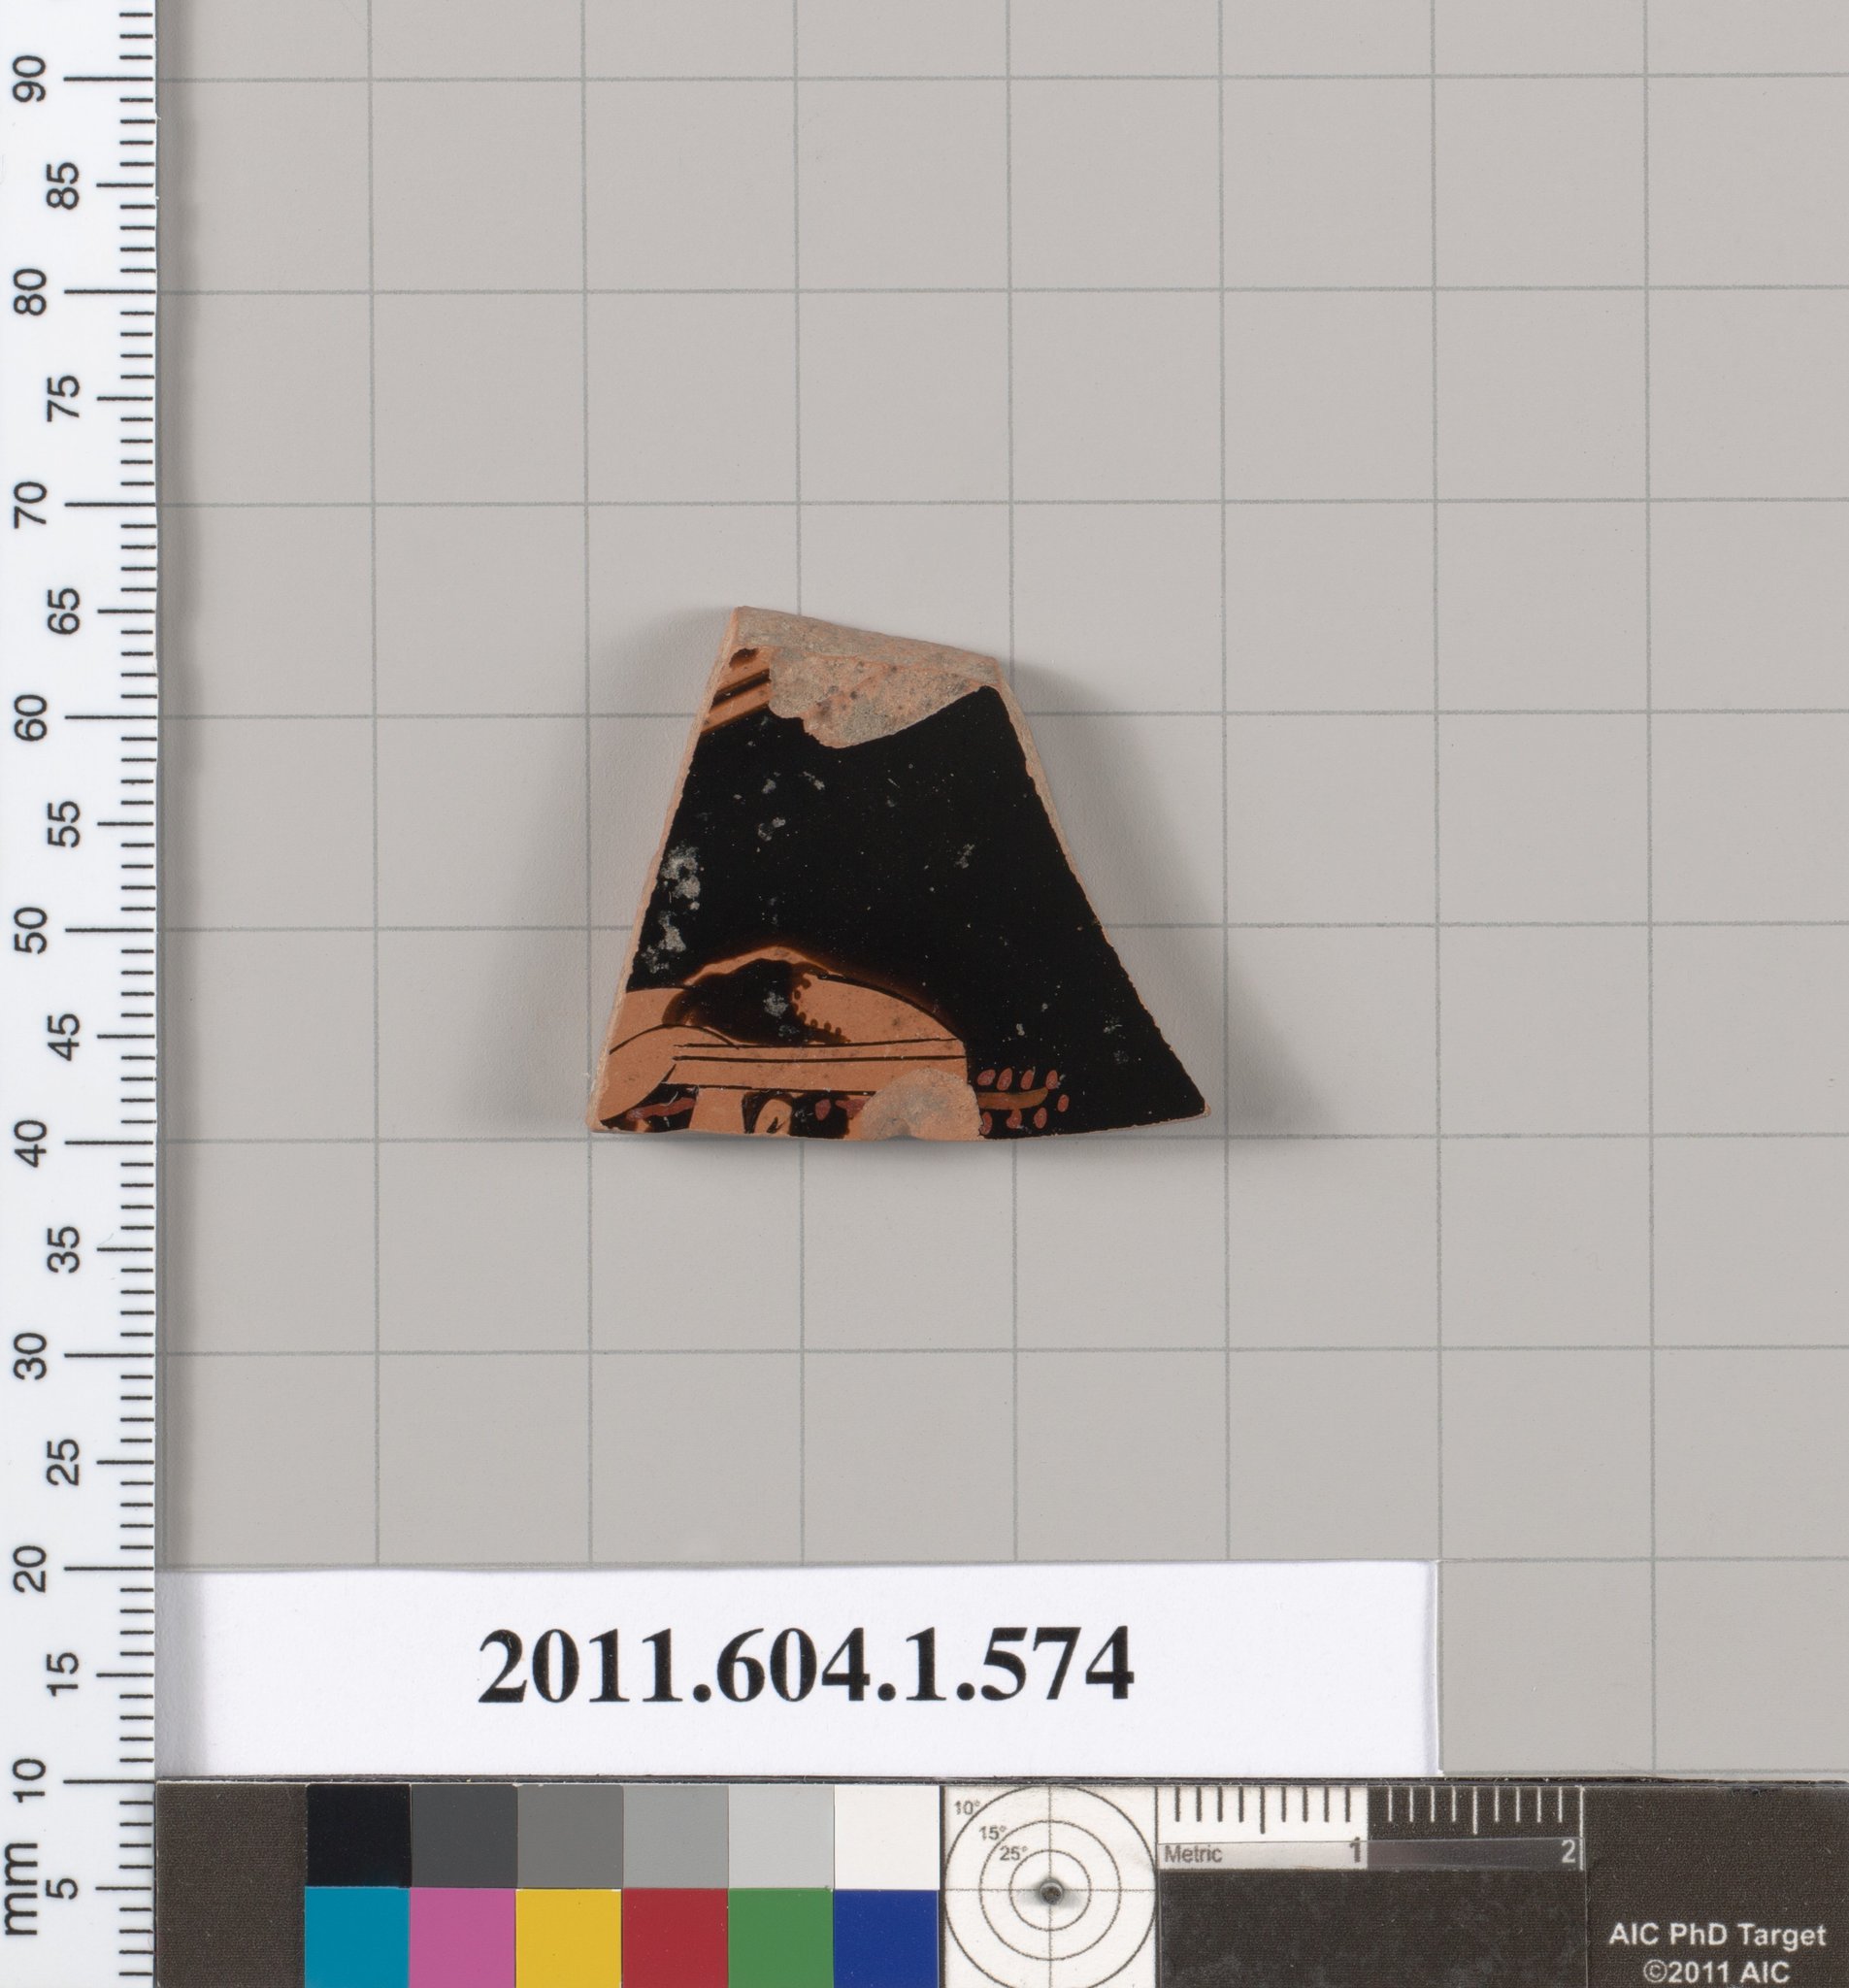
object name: kylix fragment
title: Terracotta fragment of a kylix (drinking cup)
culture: greek, attic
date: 490-480 BCE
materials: terracotta